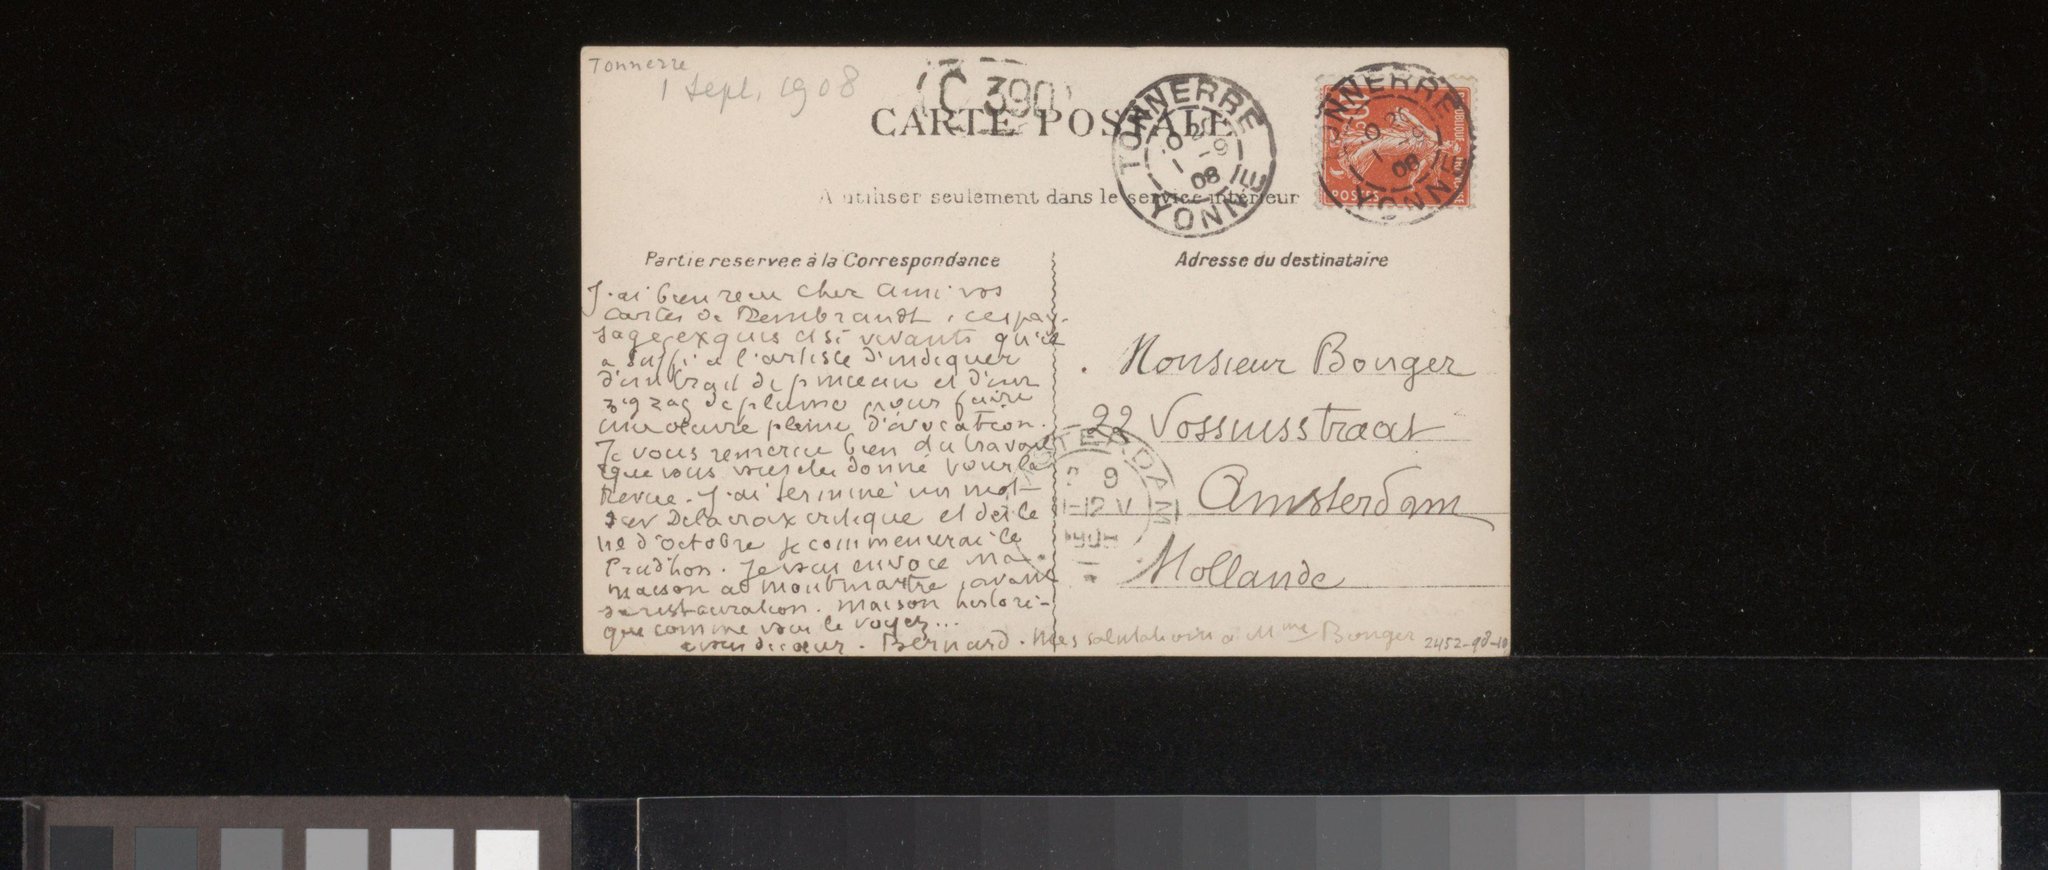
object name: ansichtkaart, prentbriefkaart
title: Prentbriefkaart aan Andries Bonger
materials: cardboard, ink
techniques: photograph, pen, writing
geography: tonnerre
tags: paris, print maker, draughtsman, eugène delacroix, rembrandt van rijn, painter, publisher, pierre prud'hon, amsterdam, andries bonger